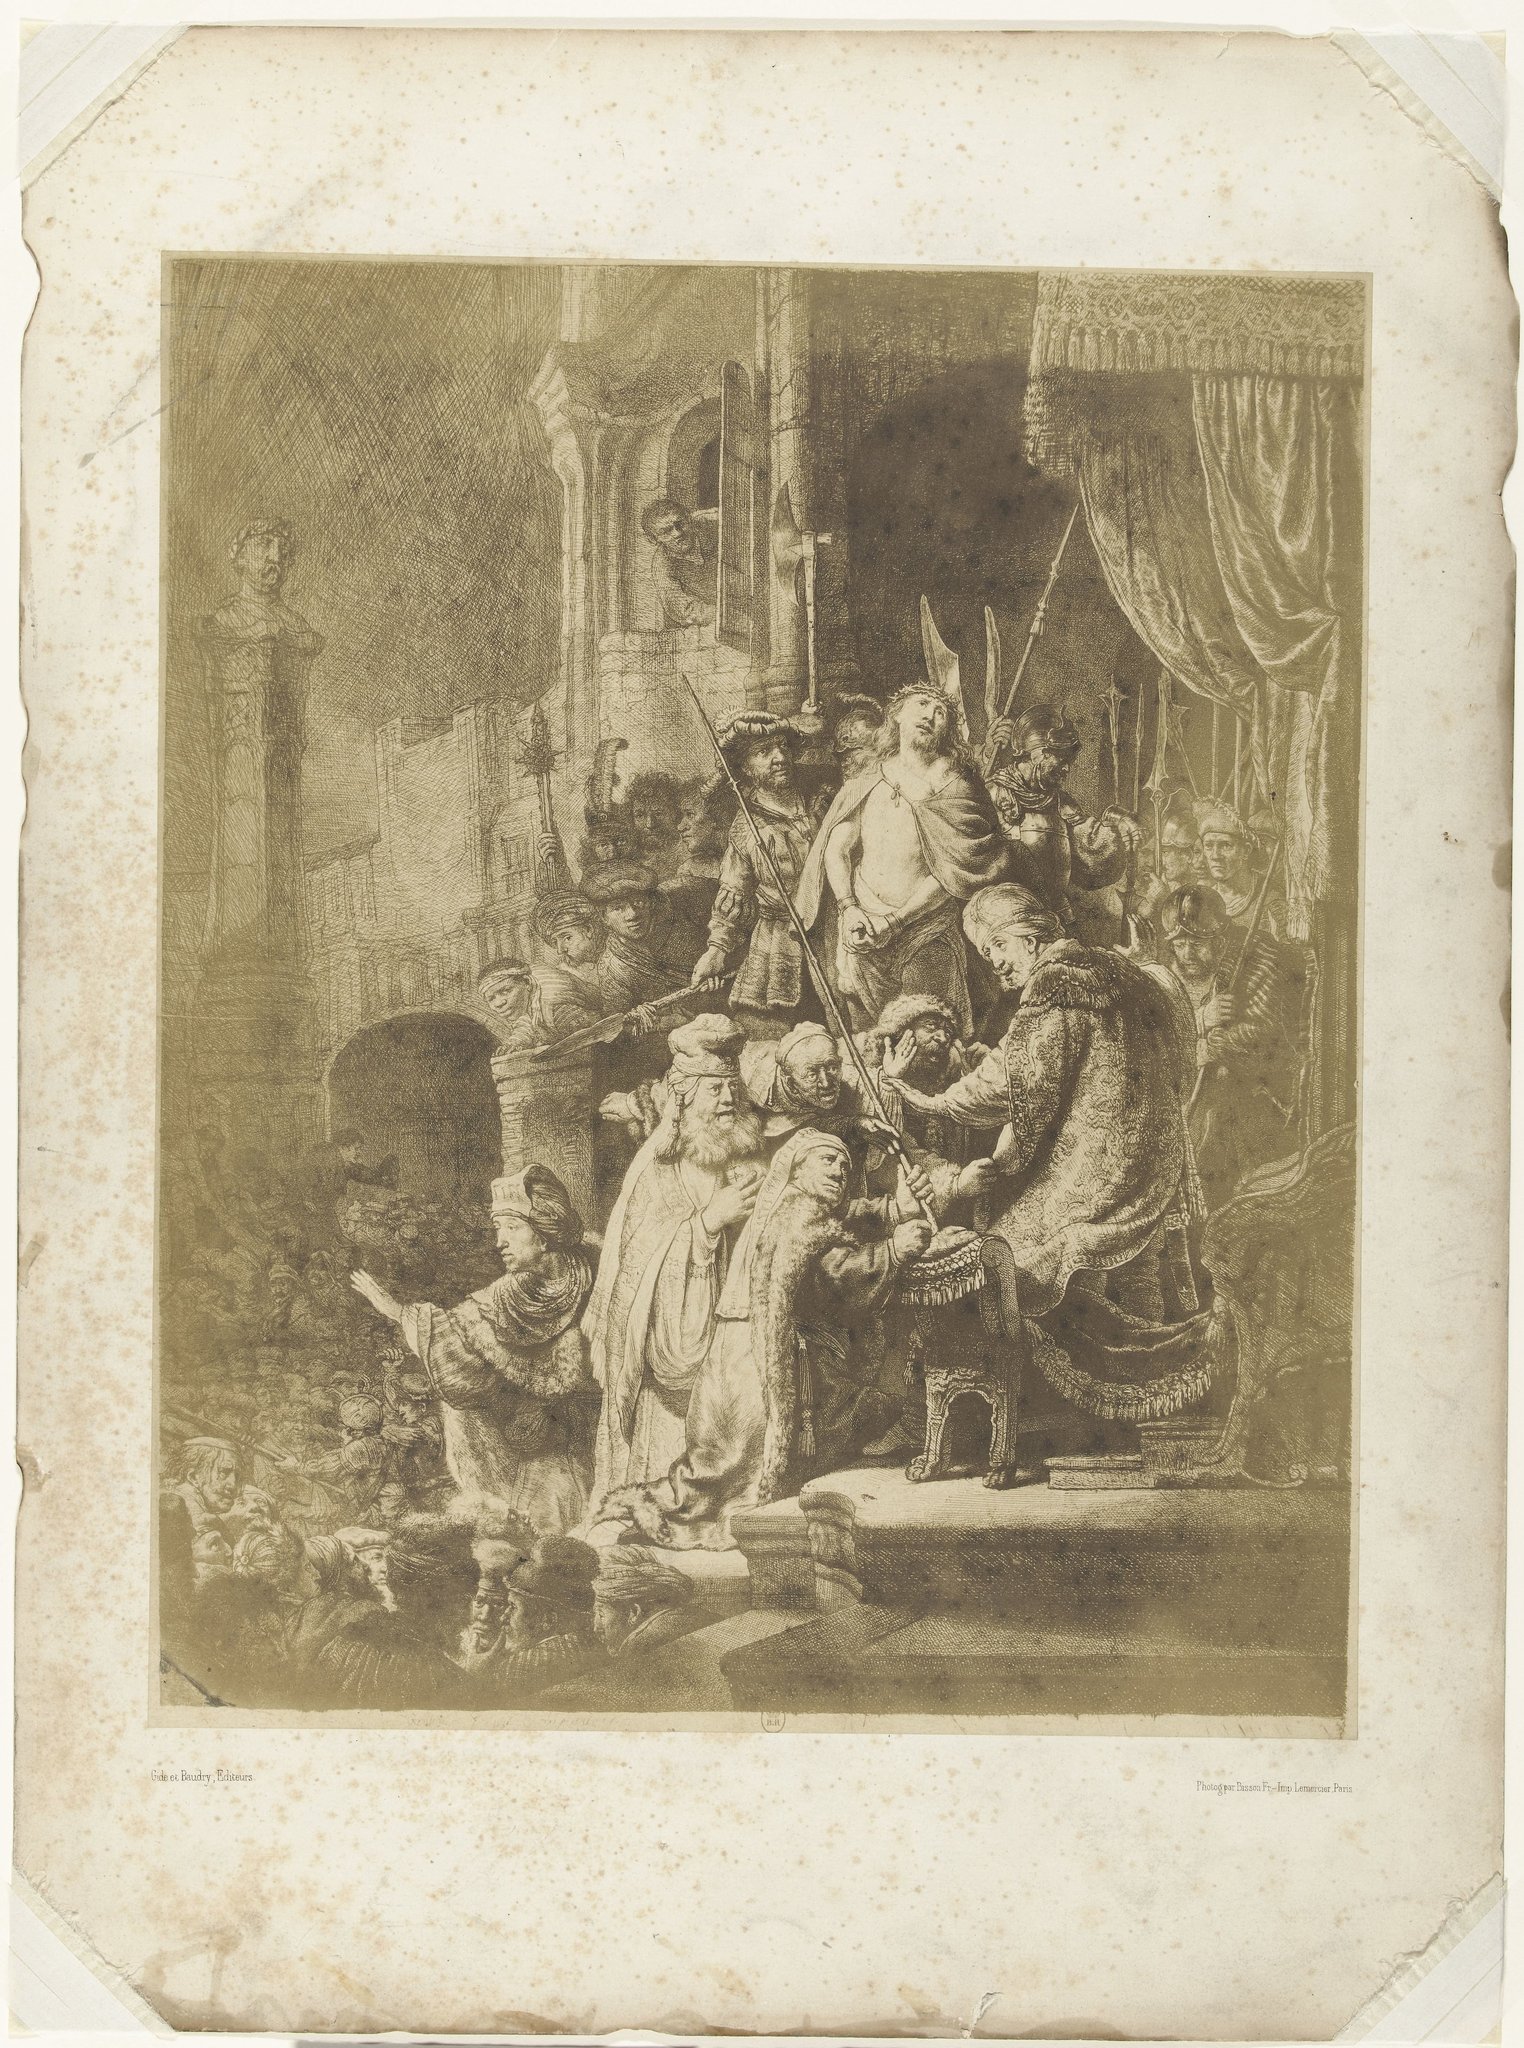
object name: photograph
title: Christus voor Pilatus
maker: joseph rose lemercier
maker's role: printer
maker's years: 1803-1887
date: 1854-1858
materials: cardboard, photographic support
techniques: salted paper print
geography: france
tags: pilate showing christ to the people, 'ostentatio christi', 'ecce homo' (john 19:4-6)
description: Foto-reproductie van een ets van Rembrandt, 'Christus voor Pilatus' (B. 77)